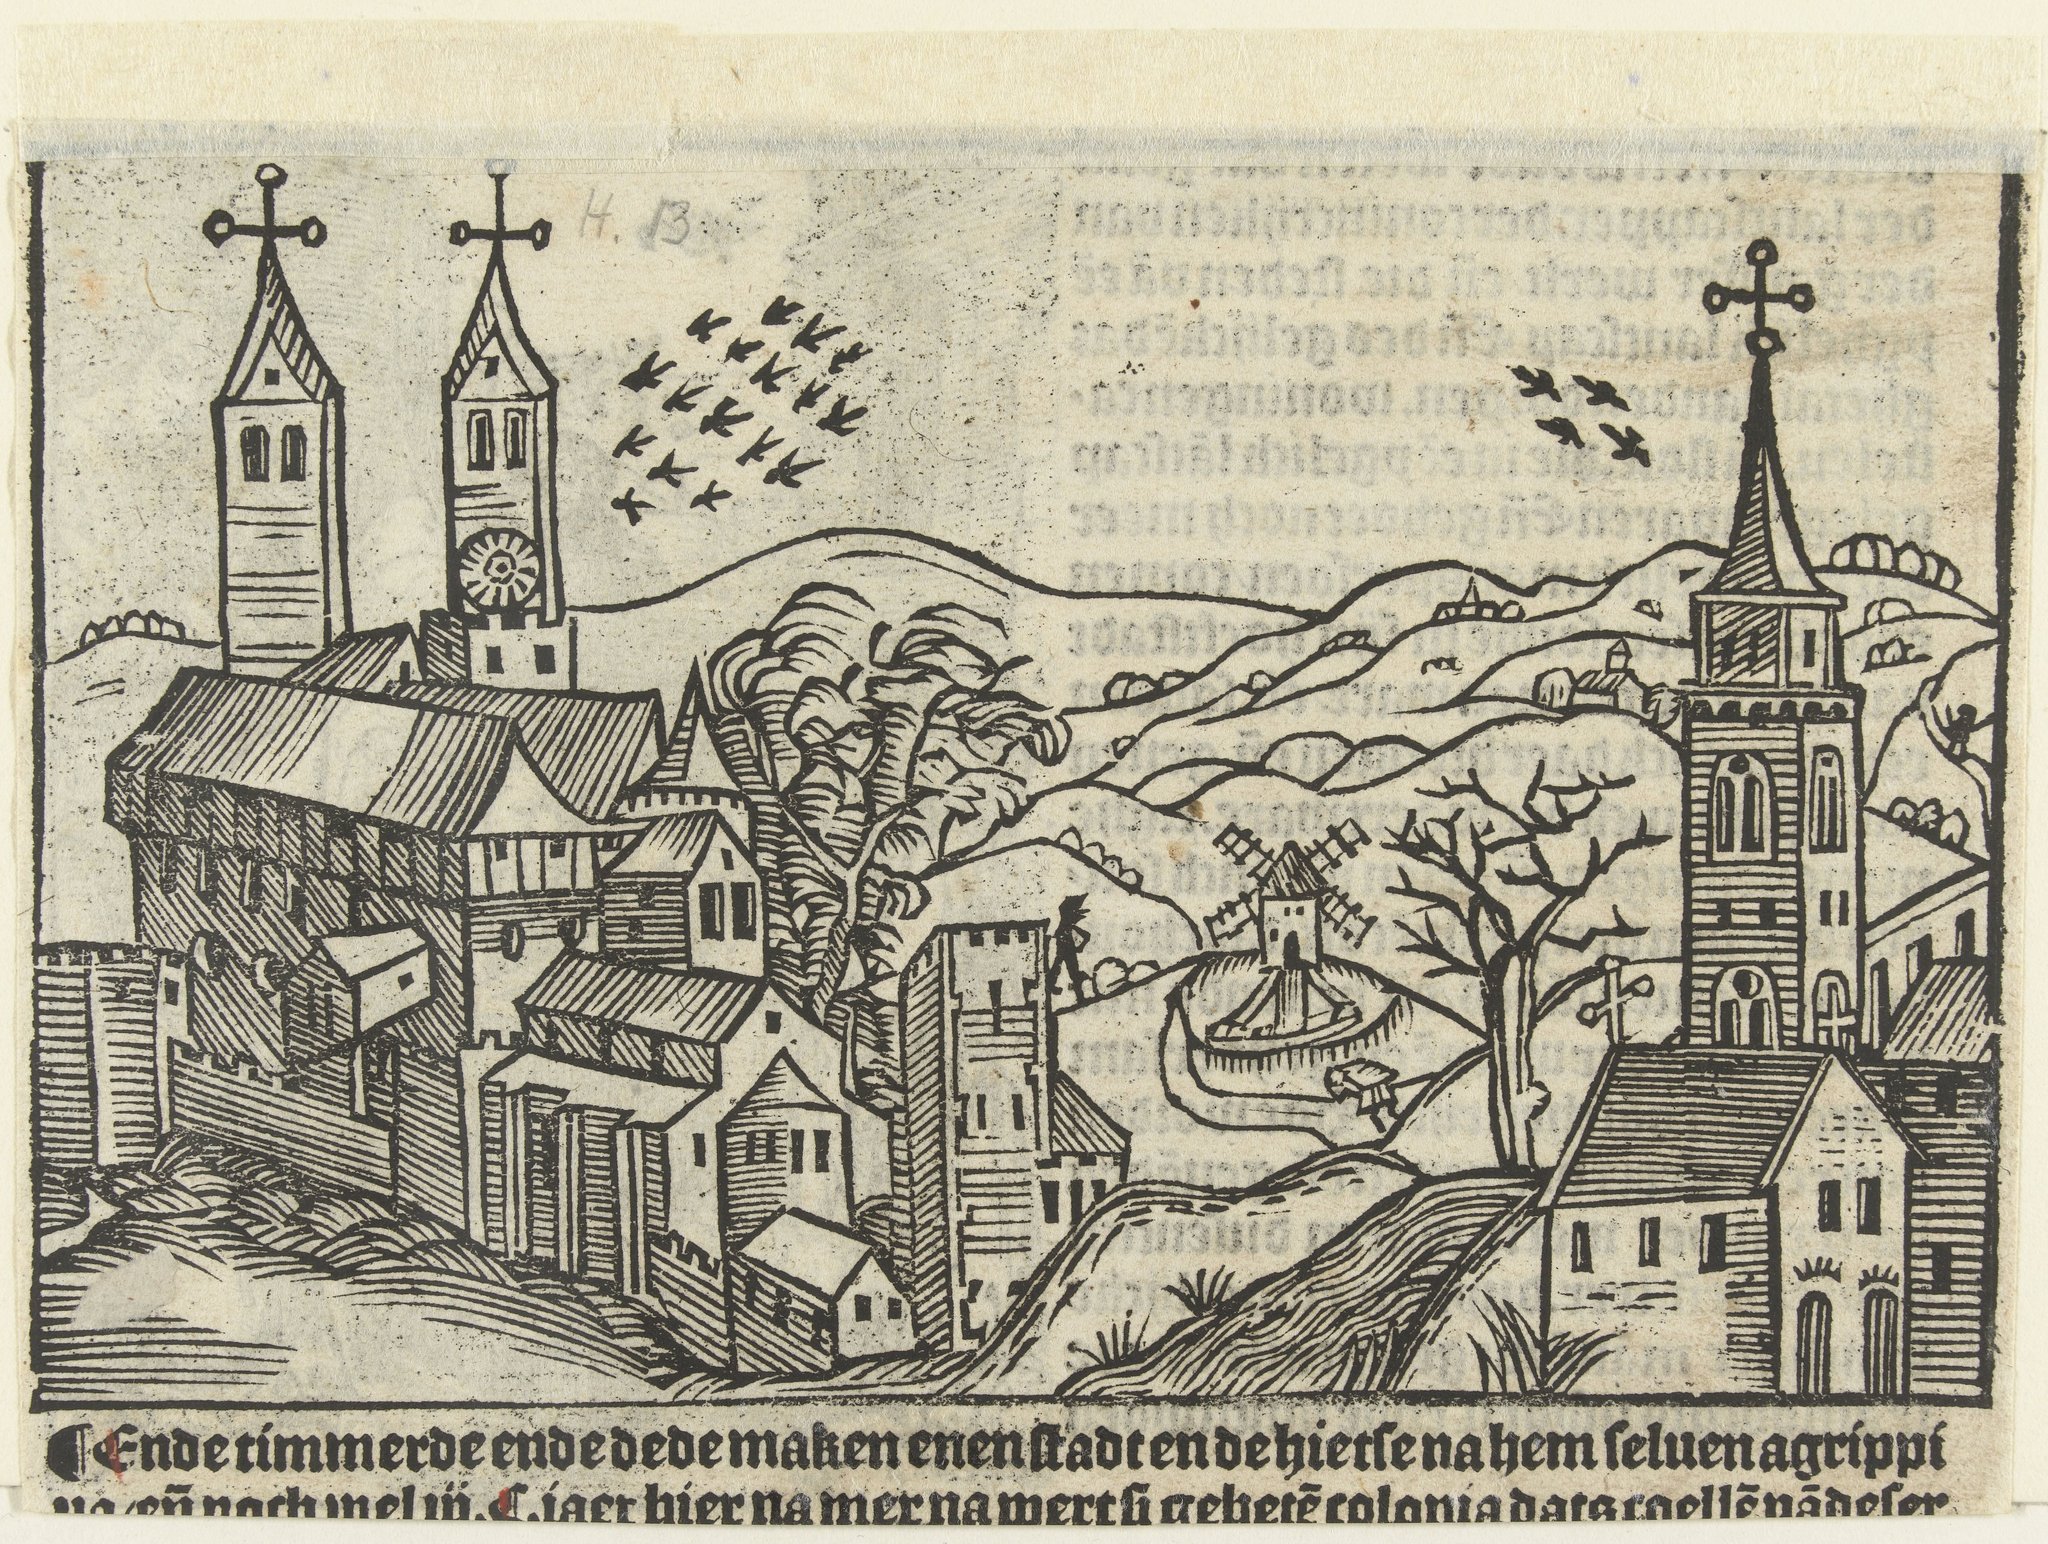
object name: book illustration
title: Gezicht op de stad Keulen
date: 1517-1530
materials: paper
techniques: woodcut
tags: city-view in general; 'veduta', cologne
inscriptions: collector's mark: Lugt 240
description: Uit "Cronycke van Hollandt, Zeelandt ende Vrieslant", uitgegeven door Jan Seversz. te Leiden. Houtsnede gebruikt in de editie van 1517 en van 1517-1530, folio 26r.